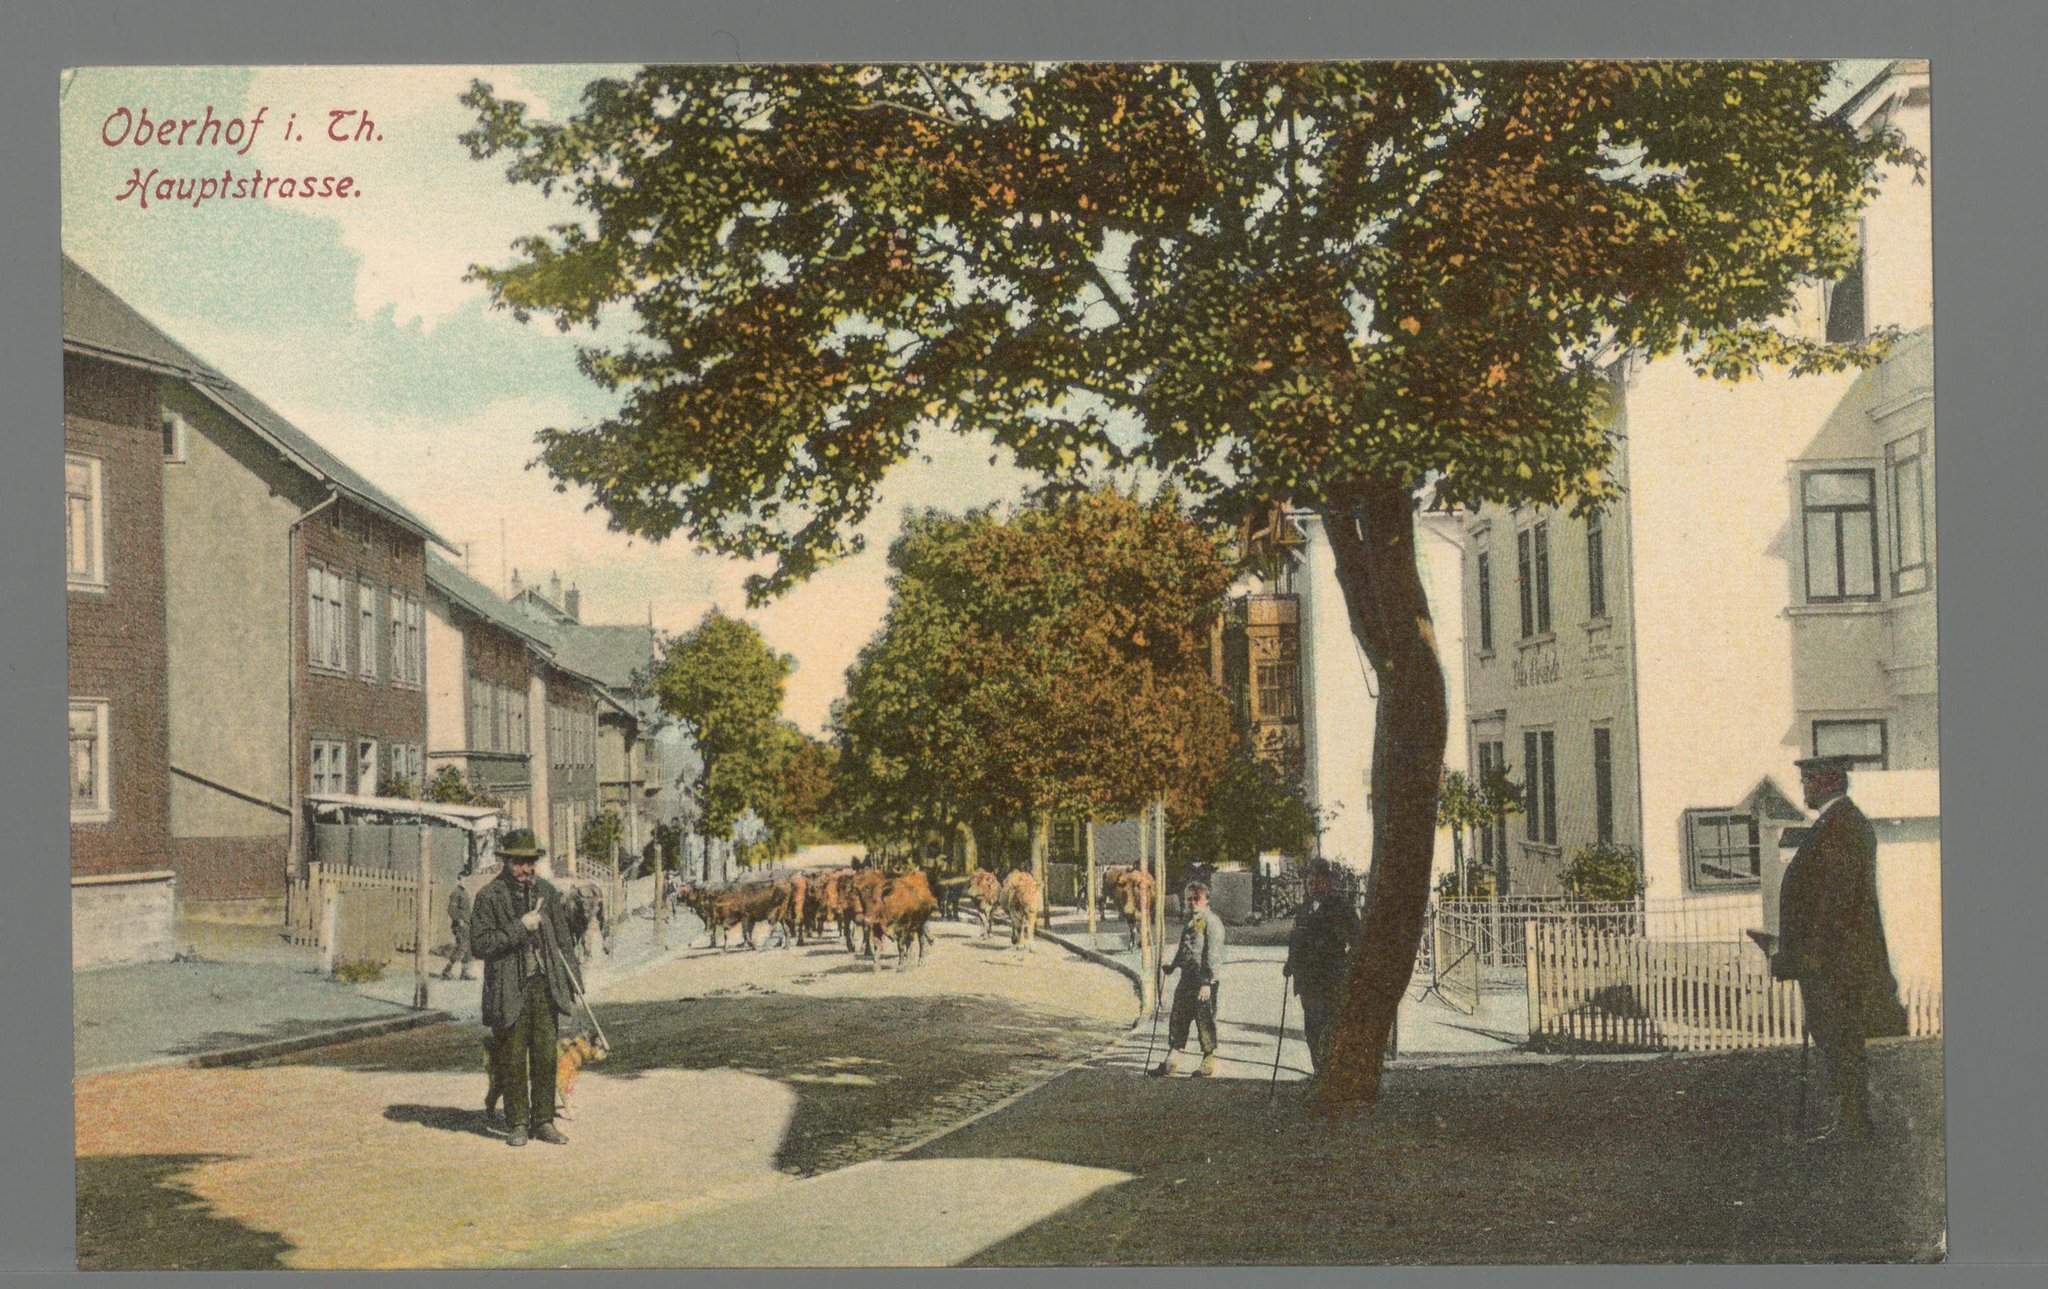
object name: ansichtkaart, prentbriefkaart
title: Oberhof i. Th. Hauptstrasse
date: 1907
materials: cardboard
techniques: photograph, lithograph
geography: steinbach-hallenberg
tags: street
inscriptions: date